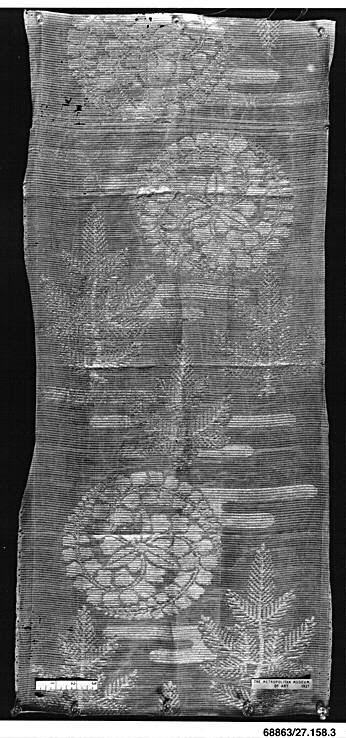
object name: length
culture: japanese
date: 1701-1800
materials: linen, metal thread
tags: flowers